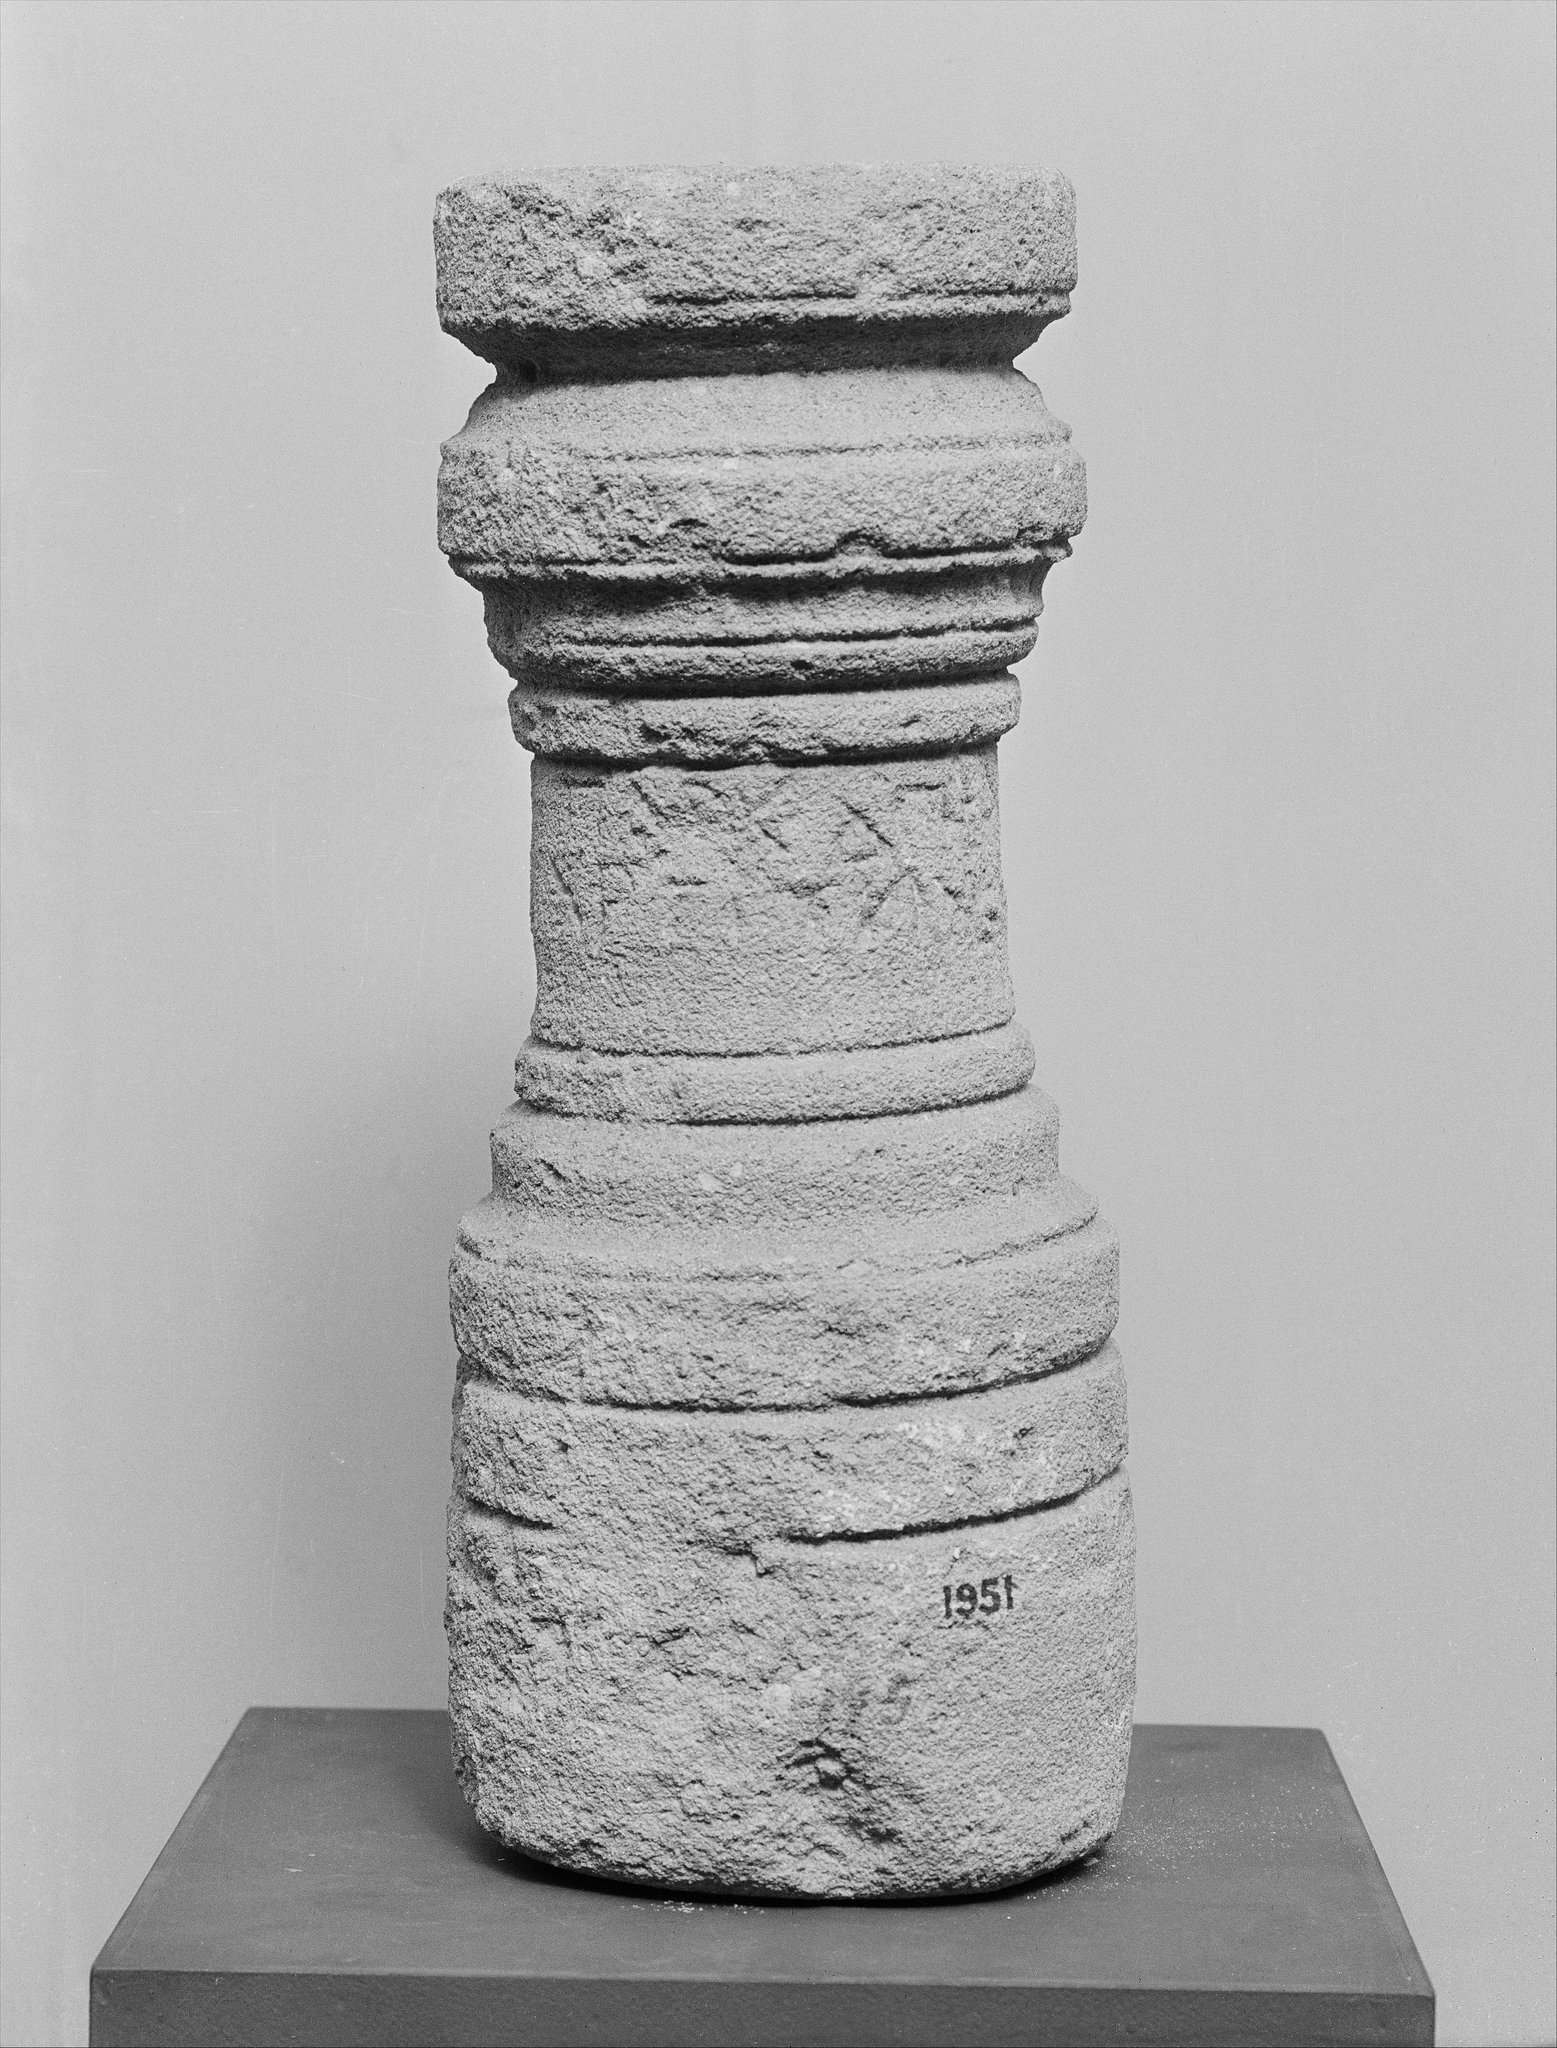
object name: cippus of marciana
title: Limestone cippus of Marciana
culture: roman, cypriot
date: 101-300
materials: limestone